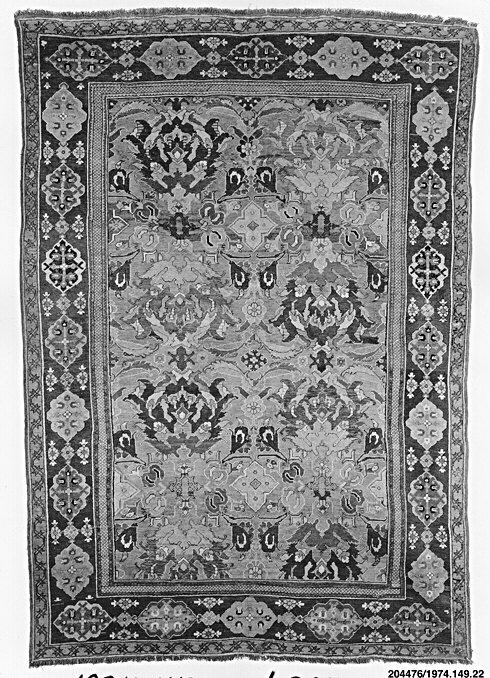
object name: carpet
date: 1299-1923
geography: turkey